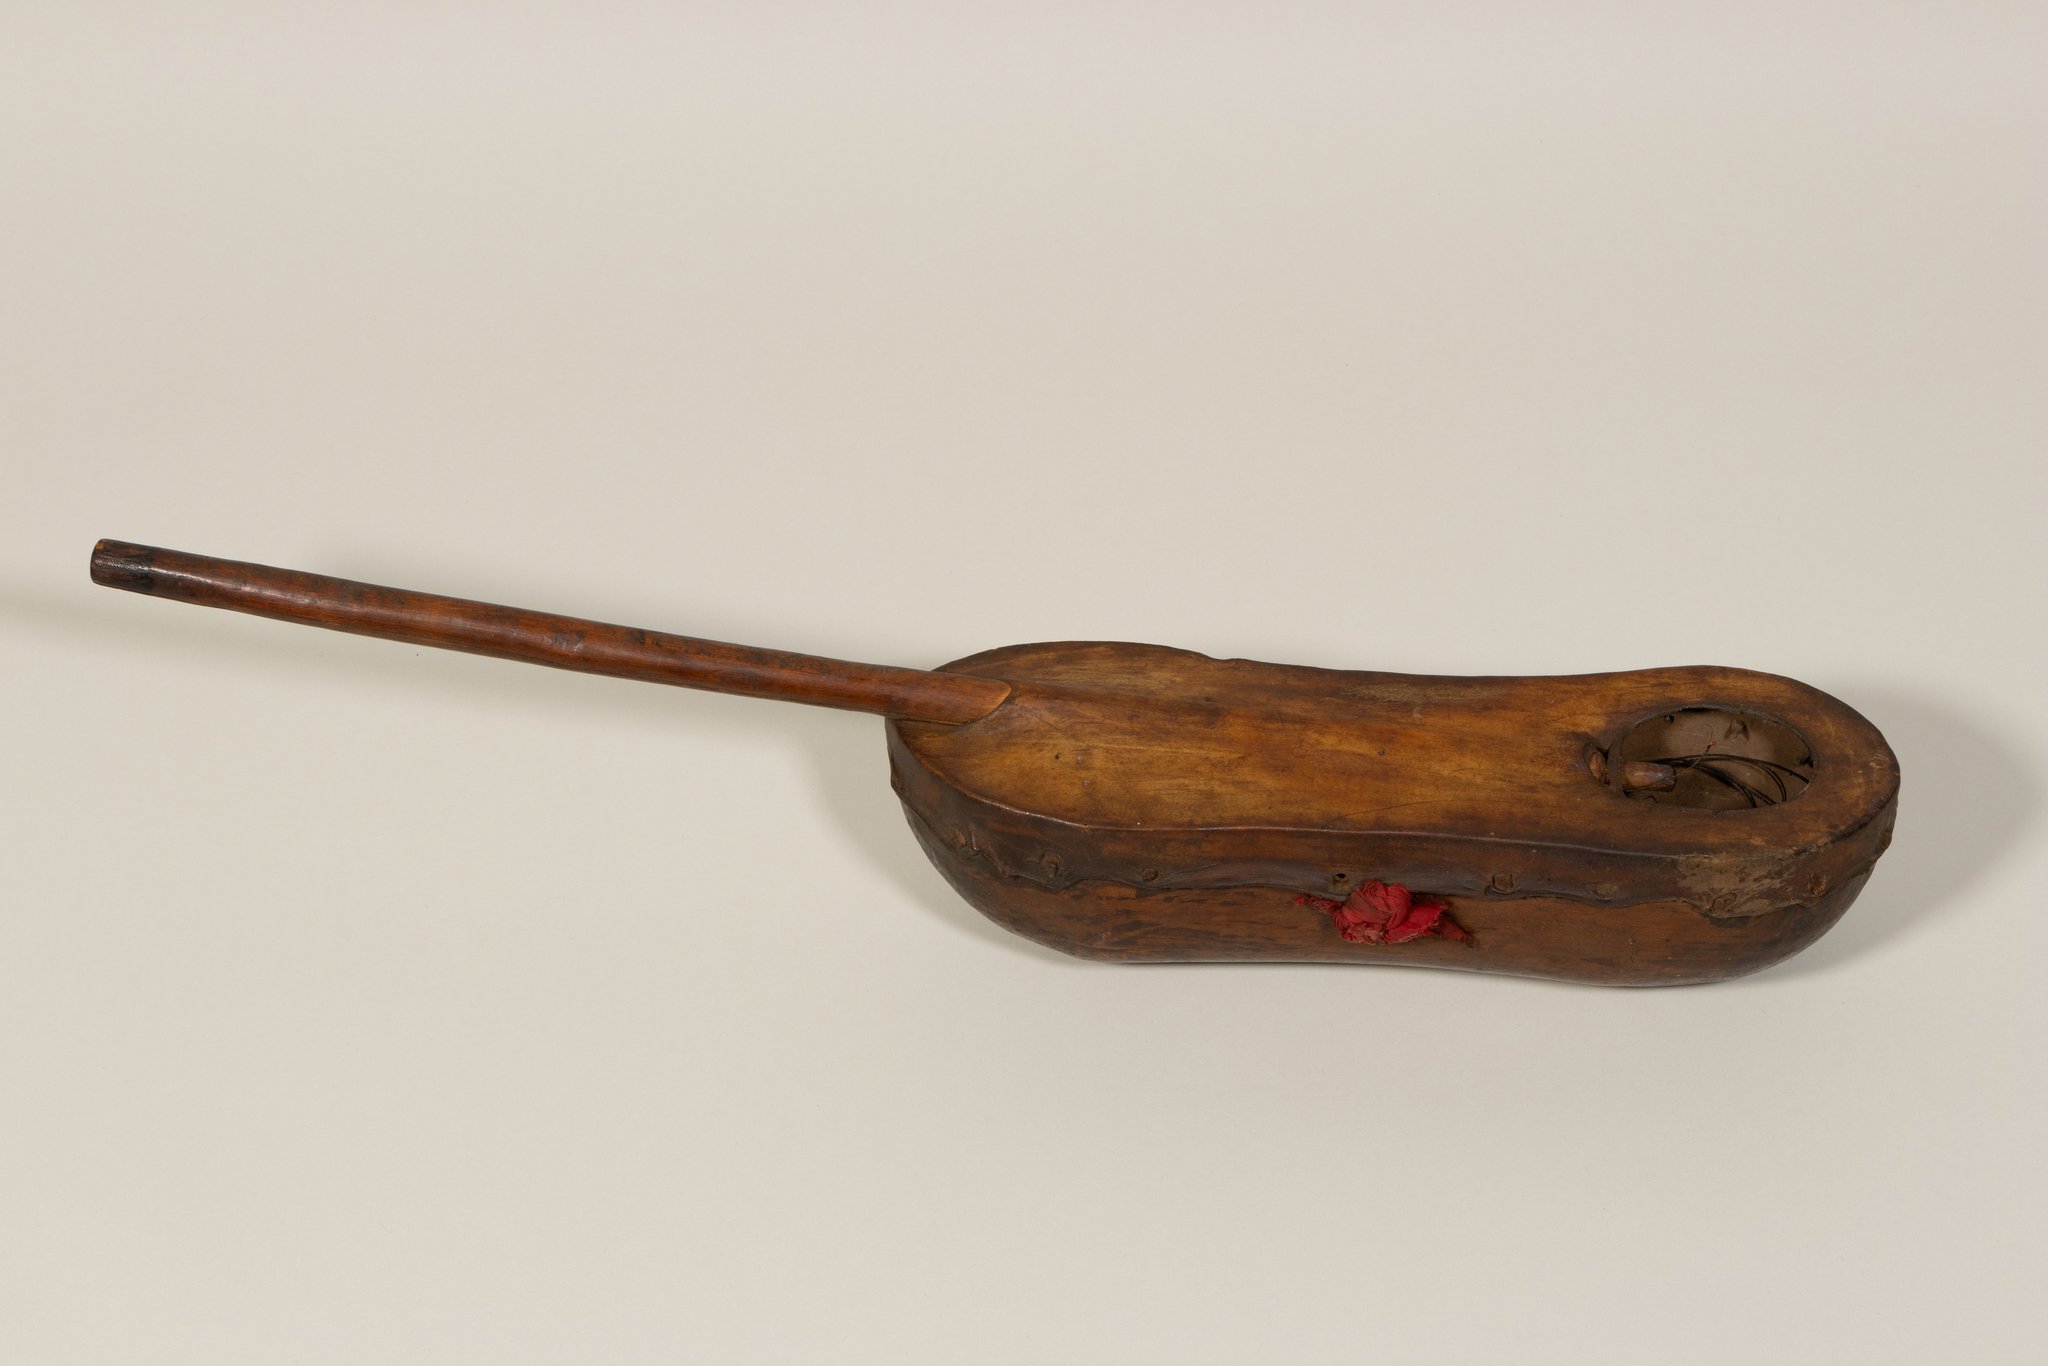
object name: hoddu xalam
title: Hoddu (Xalam)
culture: fulbe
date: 1867-1900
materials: skin, wood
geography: mali